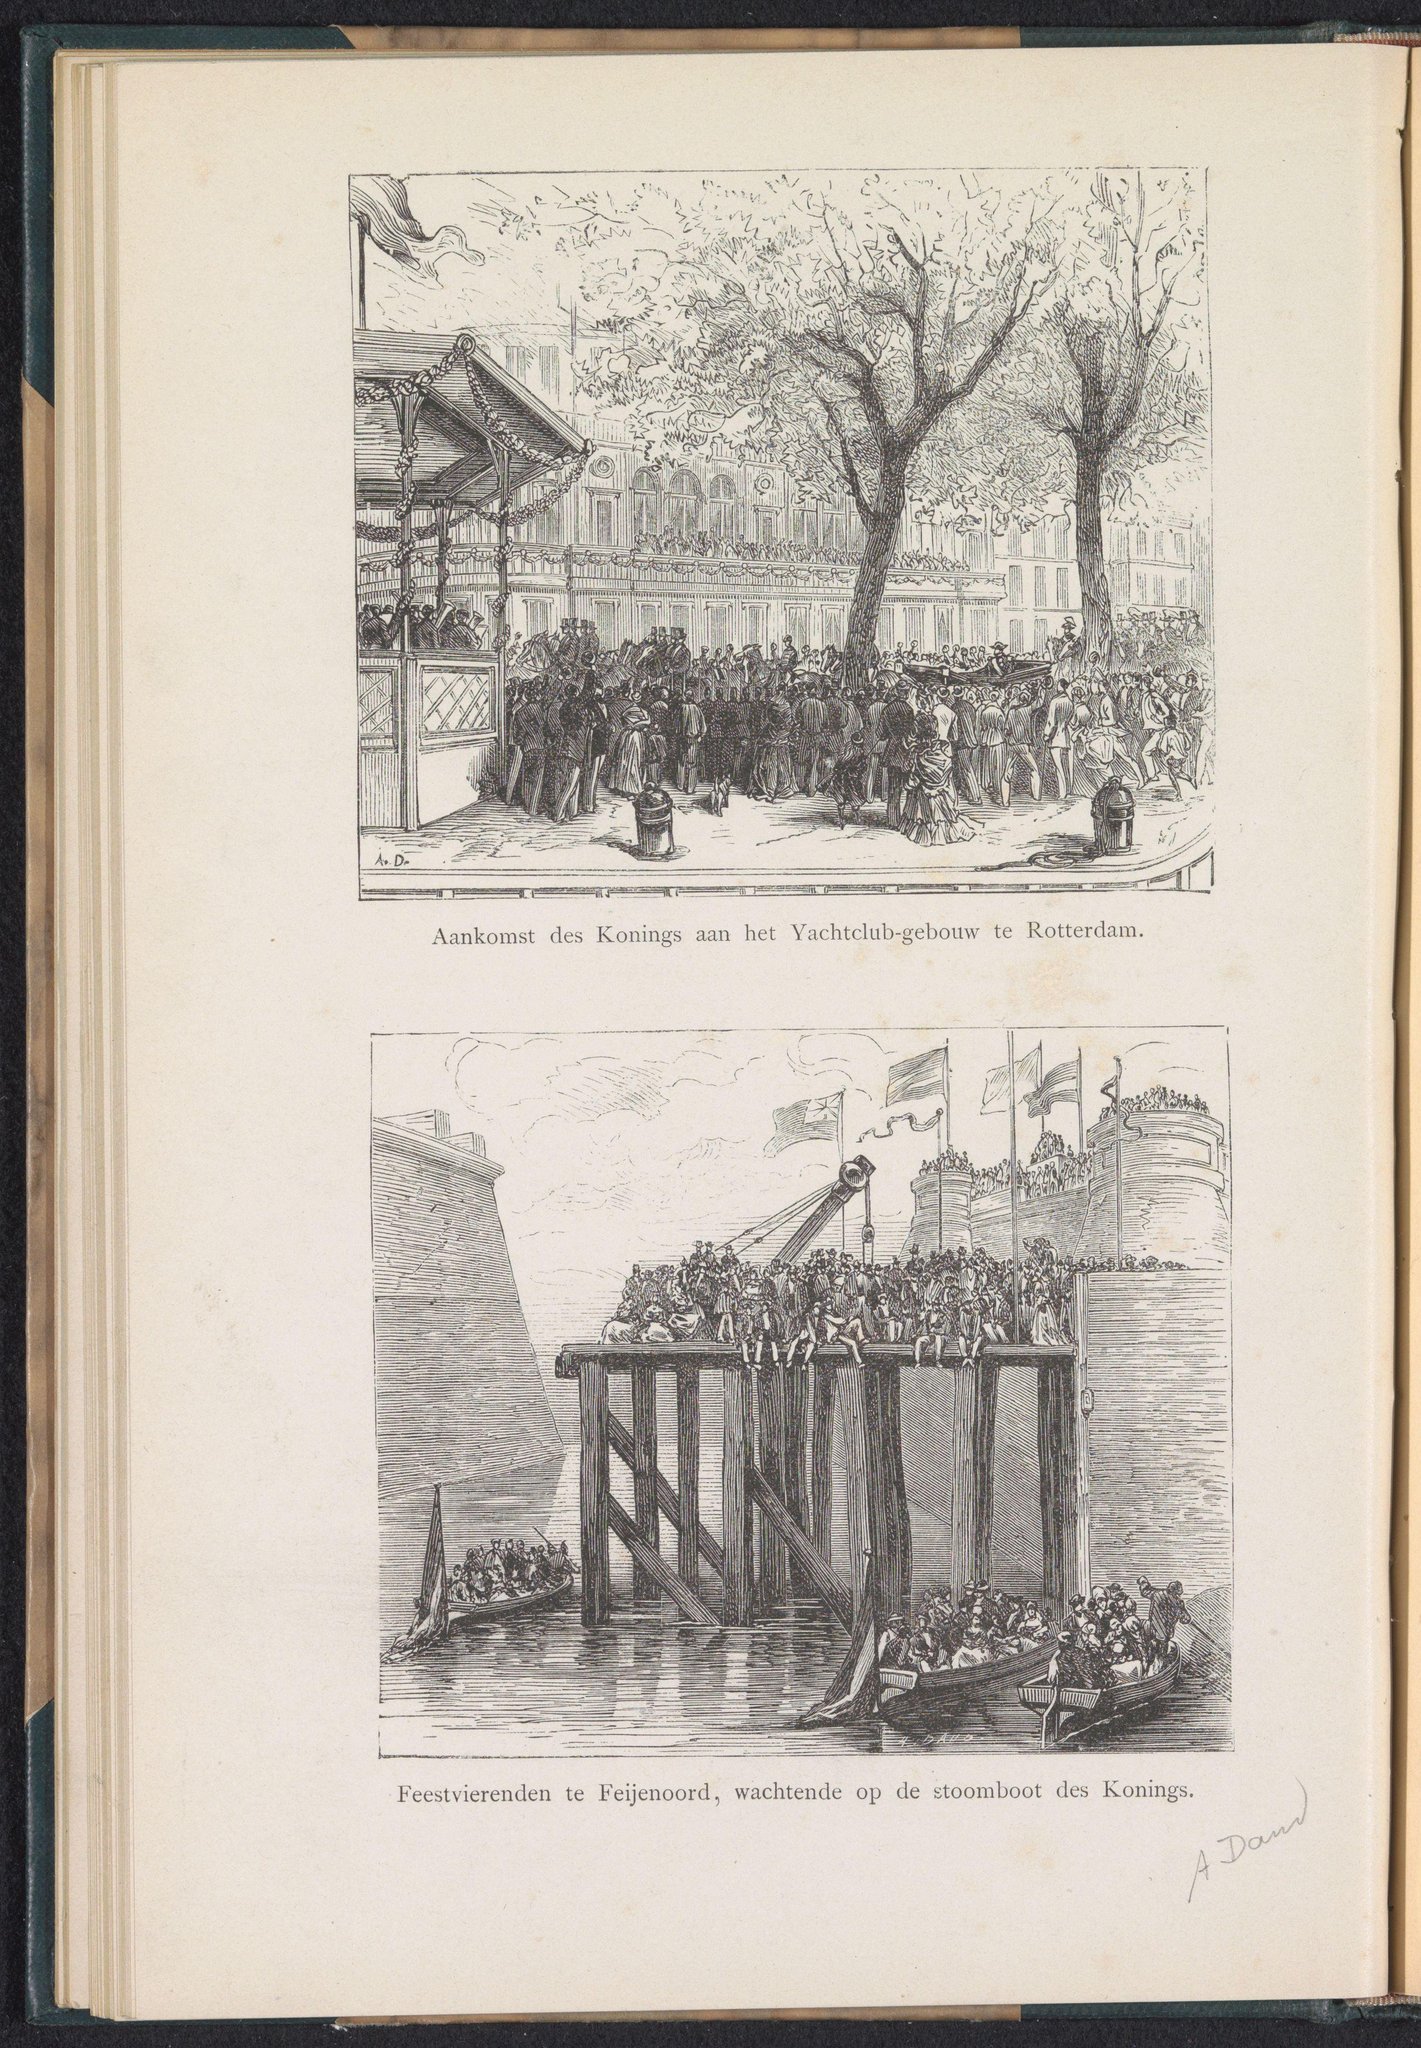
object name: print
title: Aankomst des Konings aan het Yachtclub-gebouw te Rotterdam / Feestvierenden te Feijenoord, wachtende op de stoomboot des Konings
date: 1874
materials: paper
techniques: engraving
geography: netherlands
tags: willem iii (koning der nederlanden), public festivities at other royal events, not meant or mentioned above, rotterdam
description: Blad met twee voorstellingen van het bezoek van de koning aan Rotterdam op 21 mei 1874. Boven de aankomst van de koning bij het Yachtclubgebouw, onder publiek op een steiger te Feijenoord. Illustratie in een exemplaar van het gedenkboek van de feesten in mei 1874 ter gelegenheid van het 25-jarige regeringsjubileum van koning Willem III.